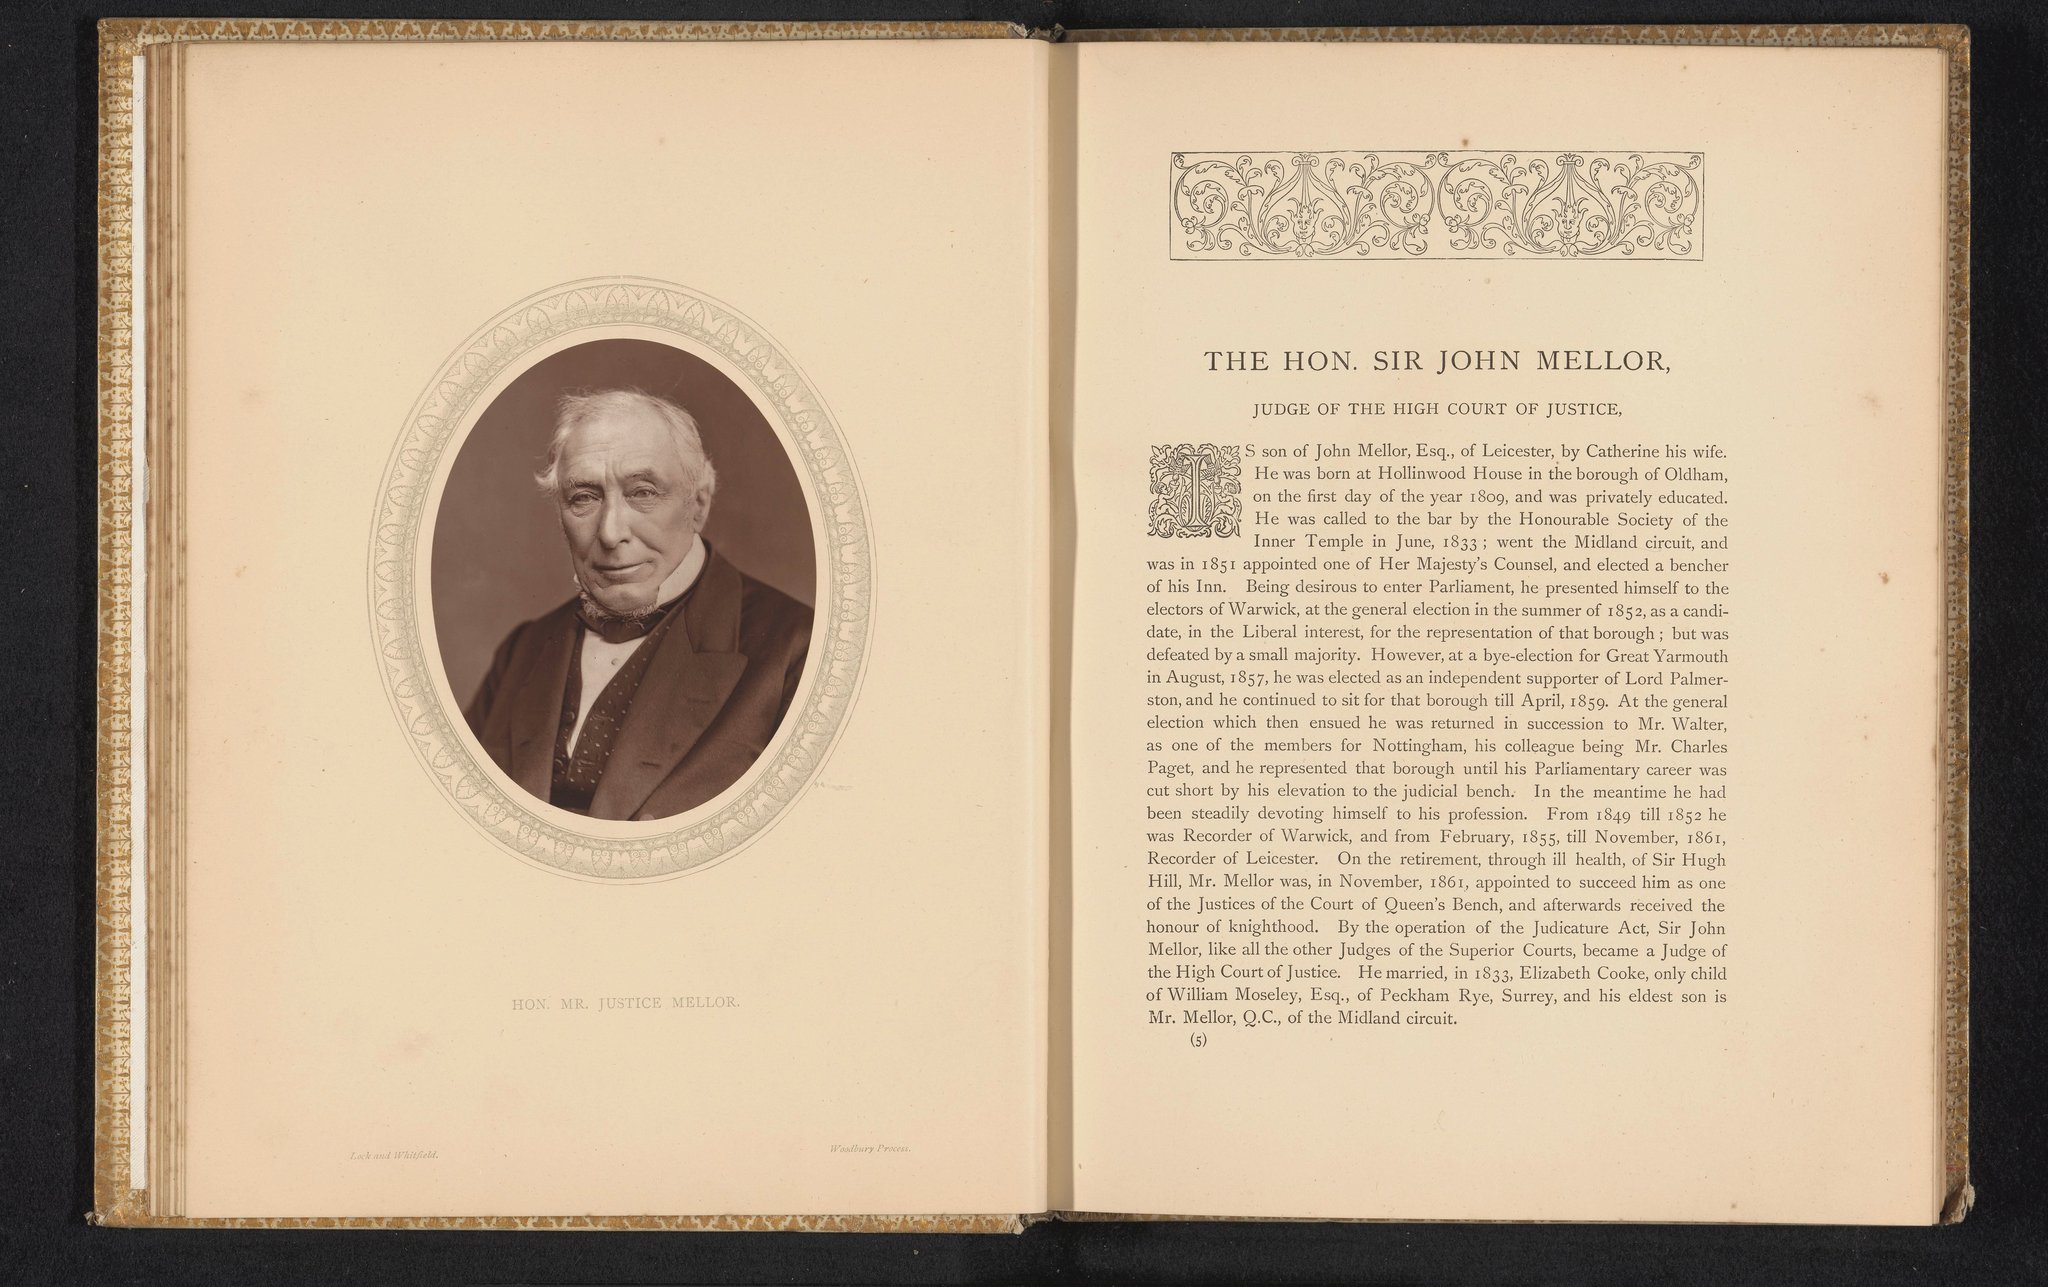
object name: photomechanical print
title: Hon. Mr. justice Mellor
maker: Anonymous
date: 1875-1880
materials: paper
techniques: woodburytype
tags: historical persons (portraits and scenes from the life) (+ (full) bust portrait), magistracy, judges